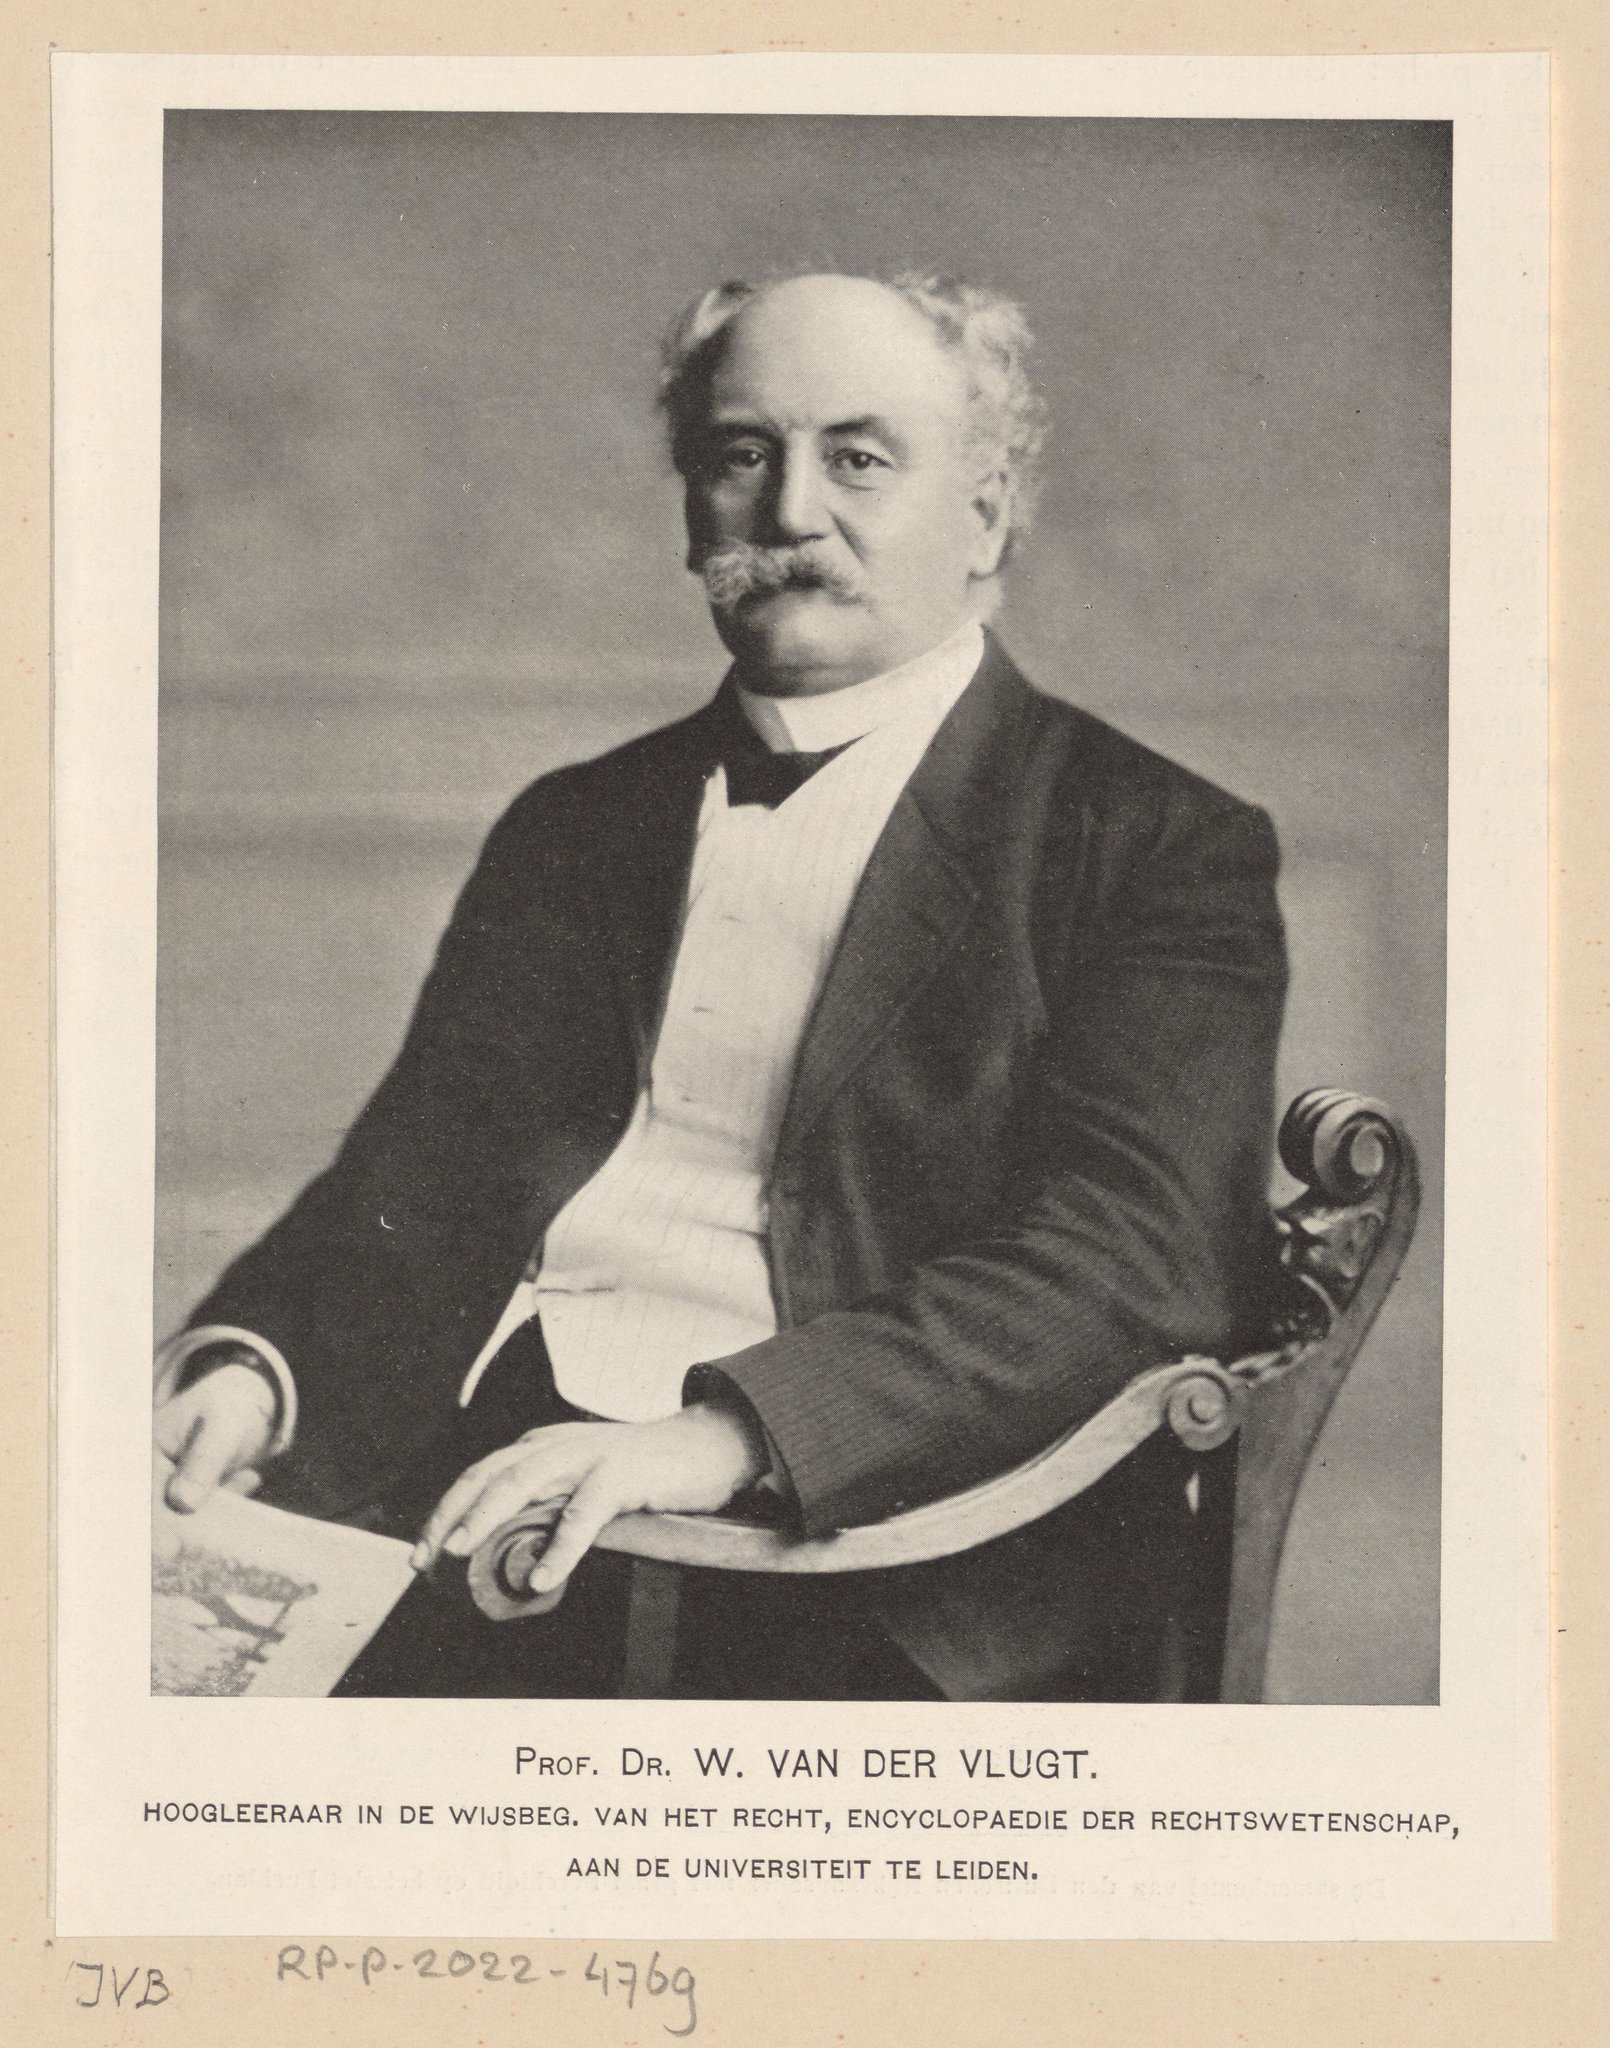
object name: photomechanical print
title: Portret van Willem van der Vlugt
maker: Anonymous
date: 1912-1923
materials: paper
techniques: letterpress printing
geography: netherlands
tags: haarlem, politician, scholar, philosopher, historical persons, politician, e.g. party leader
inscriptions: collector's mark: ‘JVB’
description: Fotomechanische afdruk komt uit een onbekende publicatie.